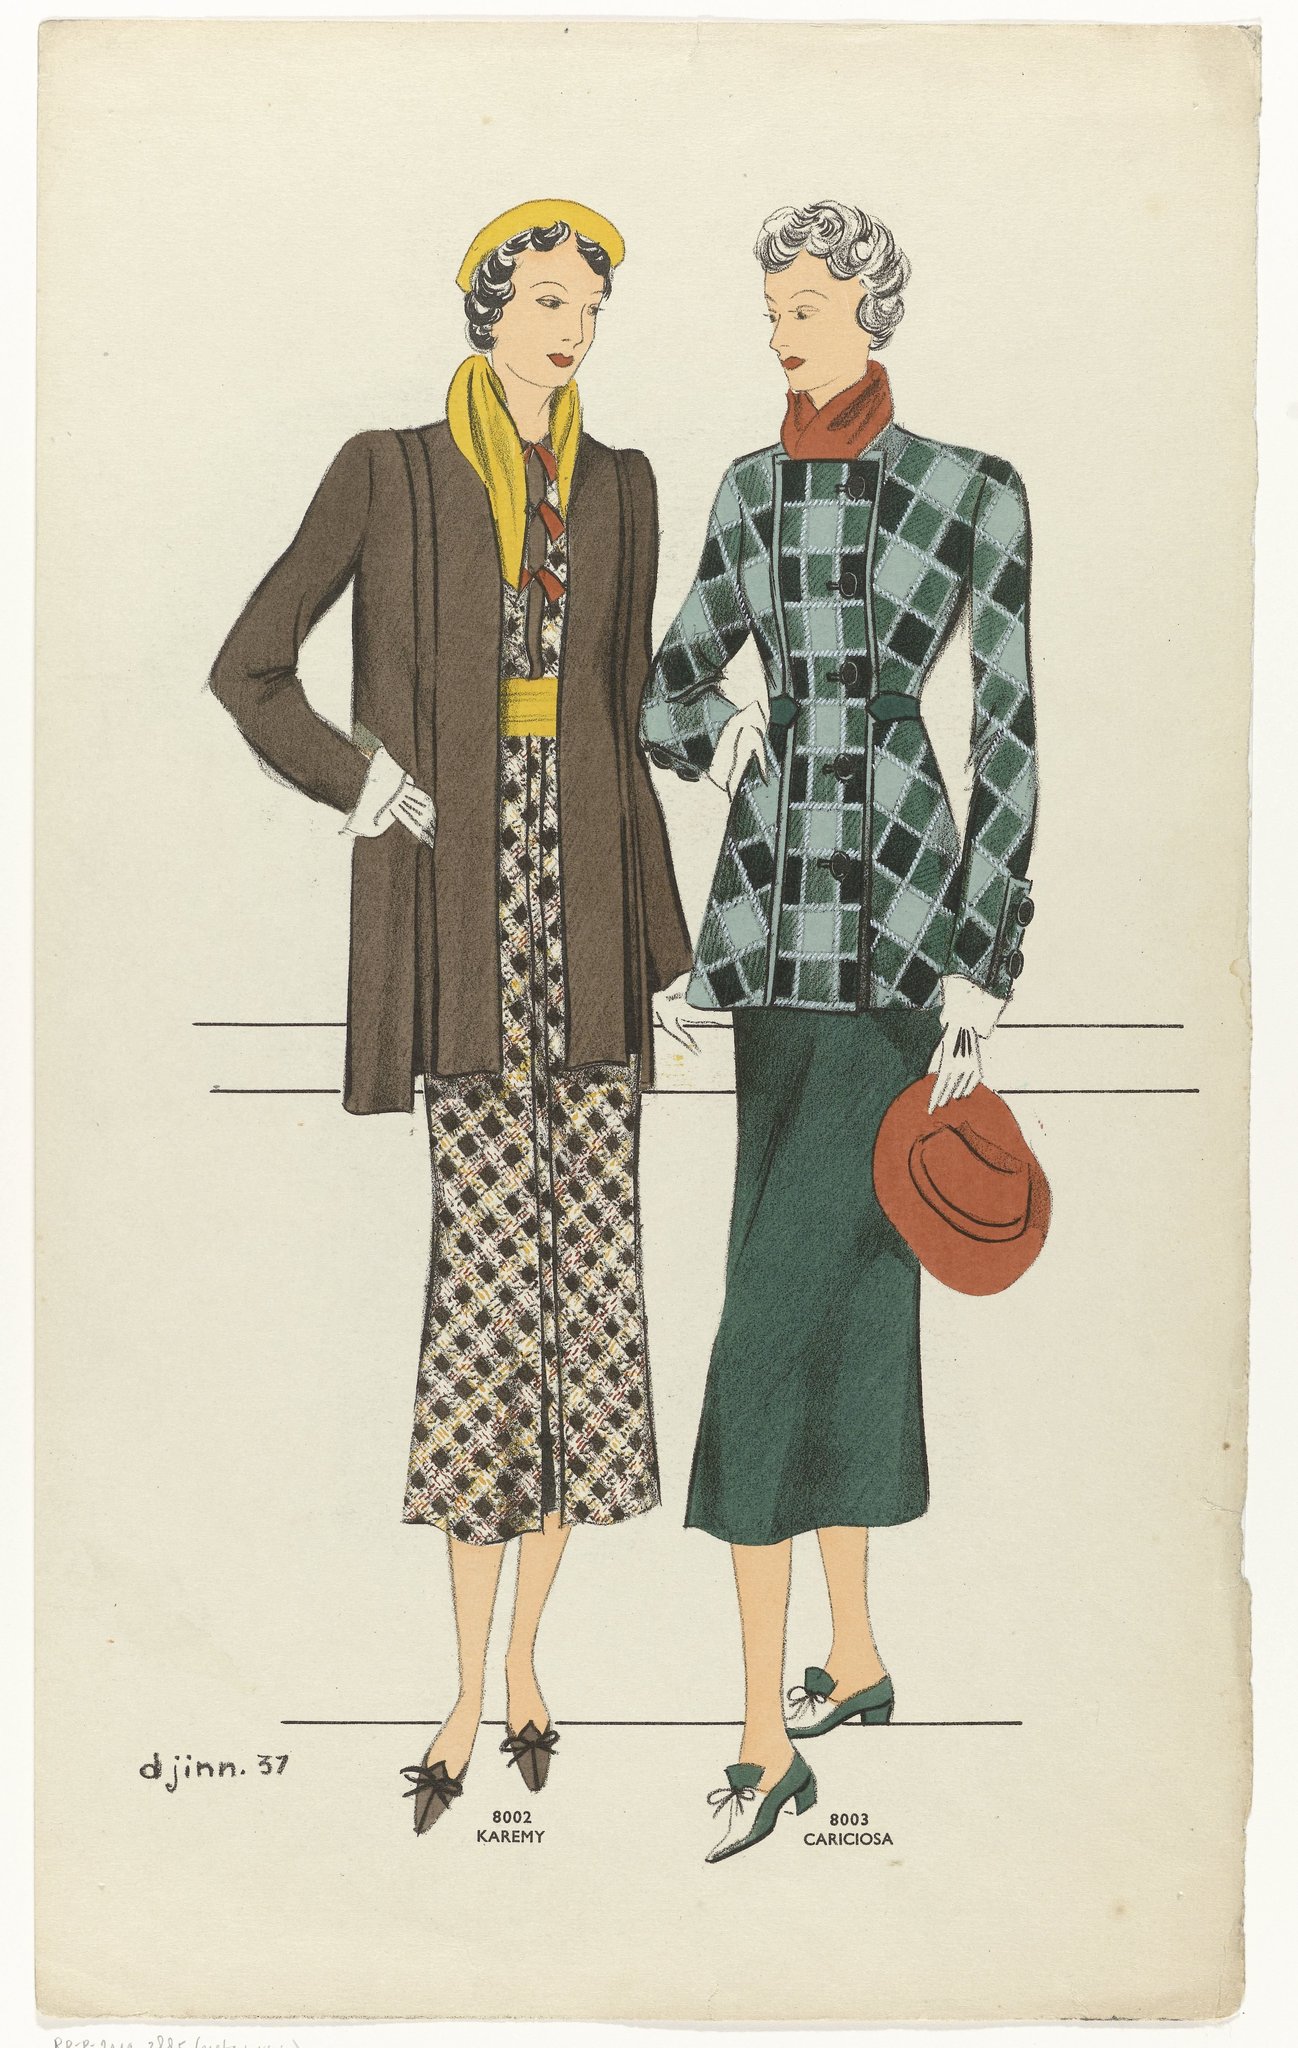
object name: fashion print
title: Djinn 1937, No. 8002 Karemy en No. 8003 Cariciosa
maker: Anonymous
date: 1937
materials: paper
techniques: hand coloring, lithograph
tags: ensembles of pieces of clothing (two piece suit) (+ women's clothes), coat (+ women's clothes), head-gear (+ women's clothes), fashion plates, head-gear: hat (+ women's clothes), skirt (+ women's clothes), dress, gown (+ women's clothes), belt, girdle, waistband (+ women's clothes)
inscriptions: caption: ‘8000 carolina Ceinture 1063 (Voir page 4 du catalogue) / 8001 Rica-Tipa’, caption: ‘8002 Karemy / 8003 Cariciosa’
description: Twee verschillende ensembles, genaamd Karemy (8002) en Cariciosa (8003). 8002: bruine jas op een geruite jurk in bruin/geel/rood. Gele hoed en sjaal. Bruine schoenen met strikken. 8003: Geruite jas in groentinten, met overslag, gesloten met vijf grote knopen. Bij de manchetten twee idem knopen. Donkergroene rok. Rode sjaal en hoed. Tweekleurige schoenen met hakken en strikken. Verso: twee ensembles, genaamd Carolina (8000) met ceintuur (1063) en Rica-Tipa (8001). De modeprent komt uit een catalogus.